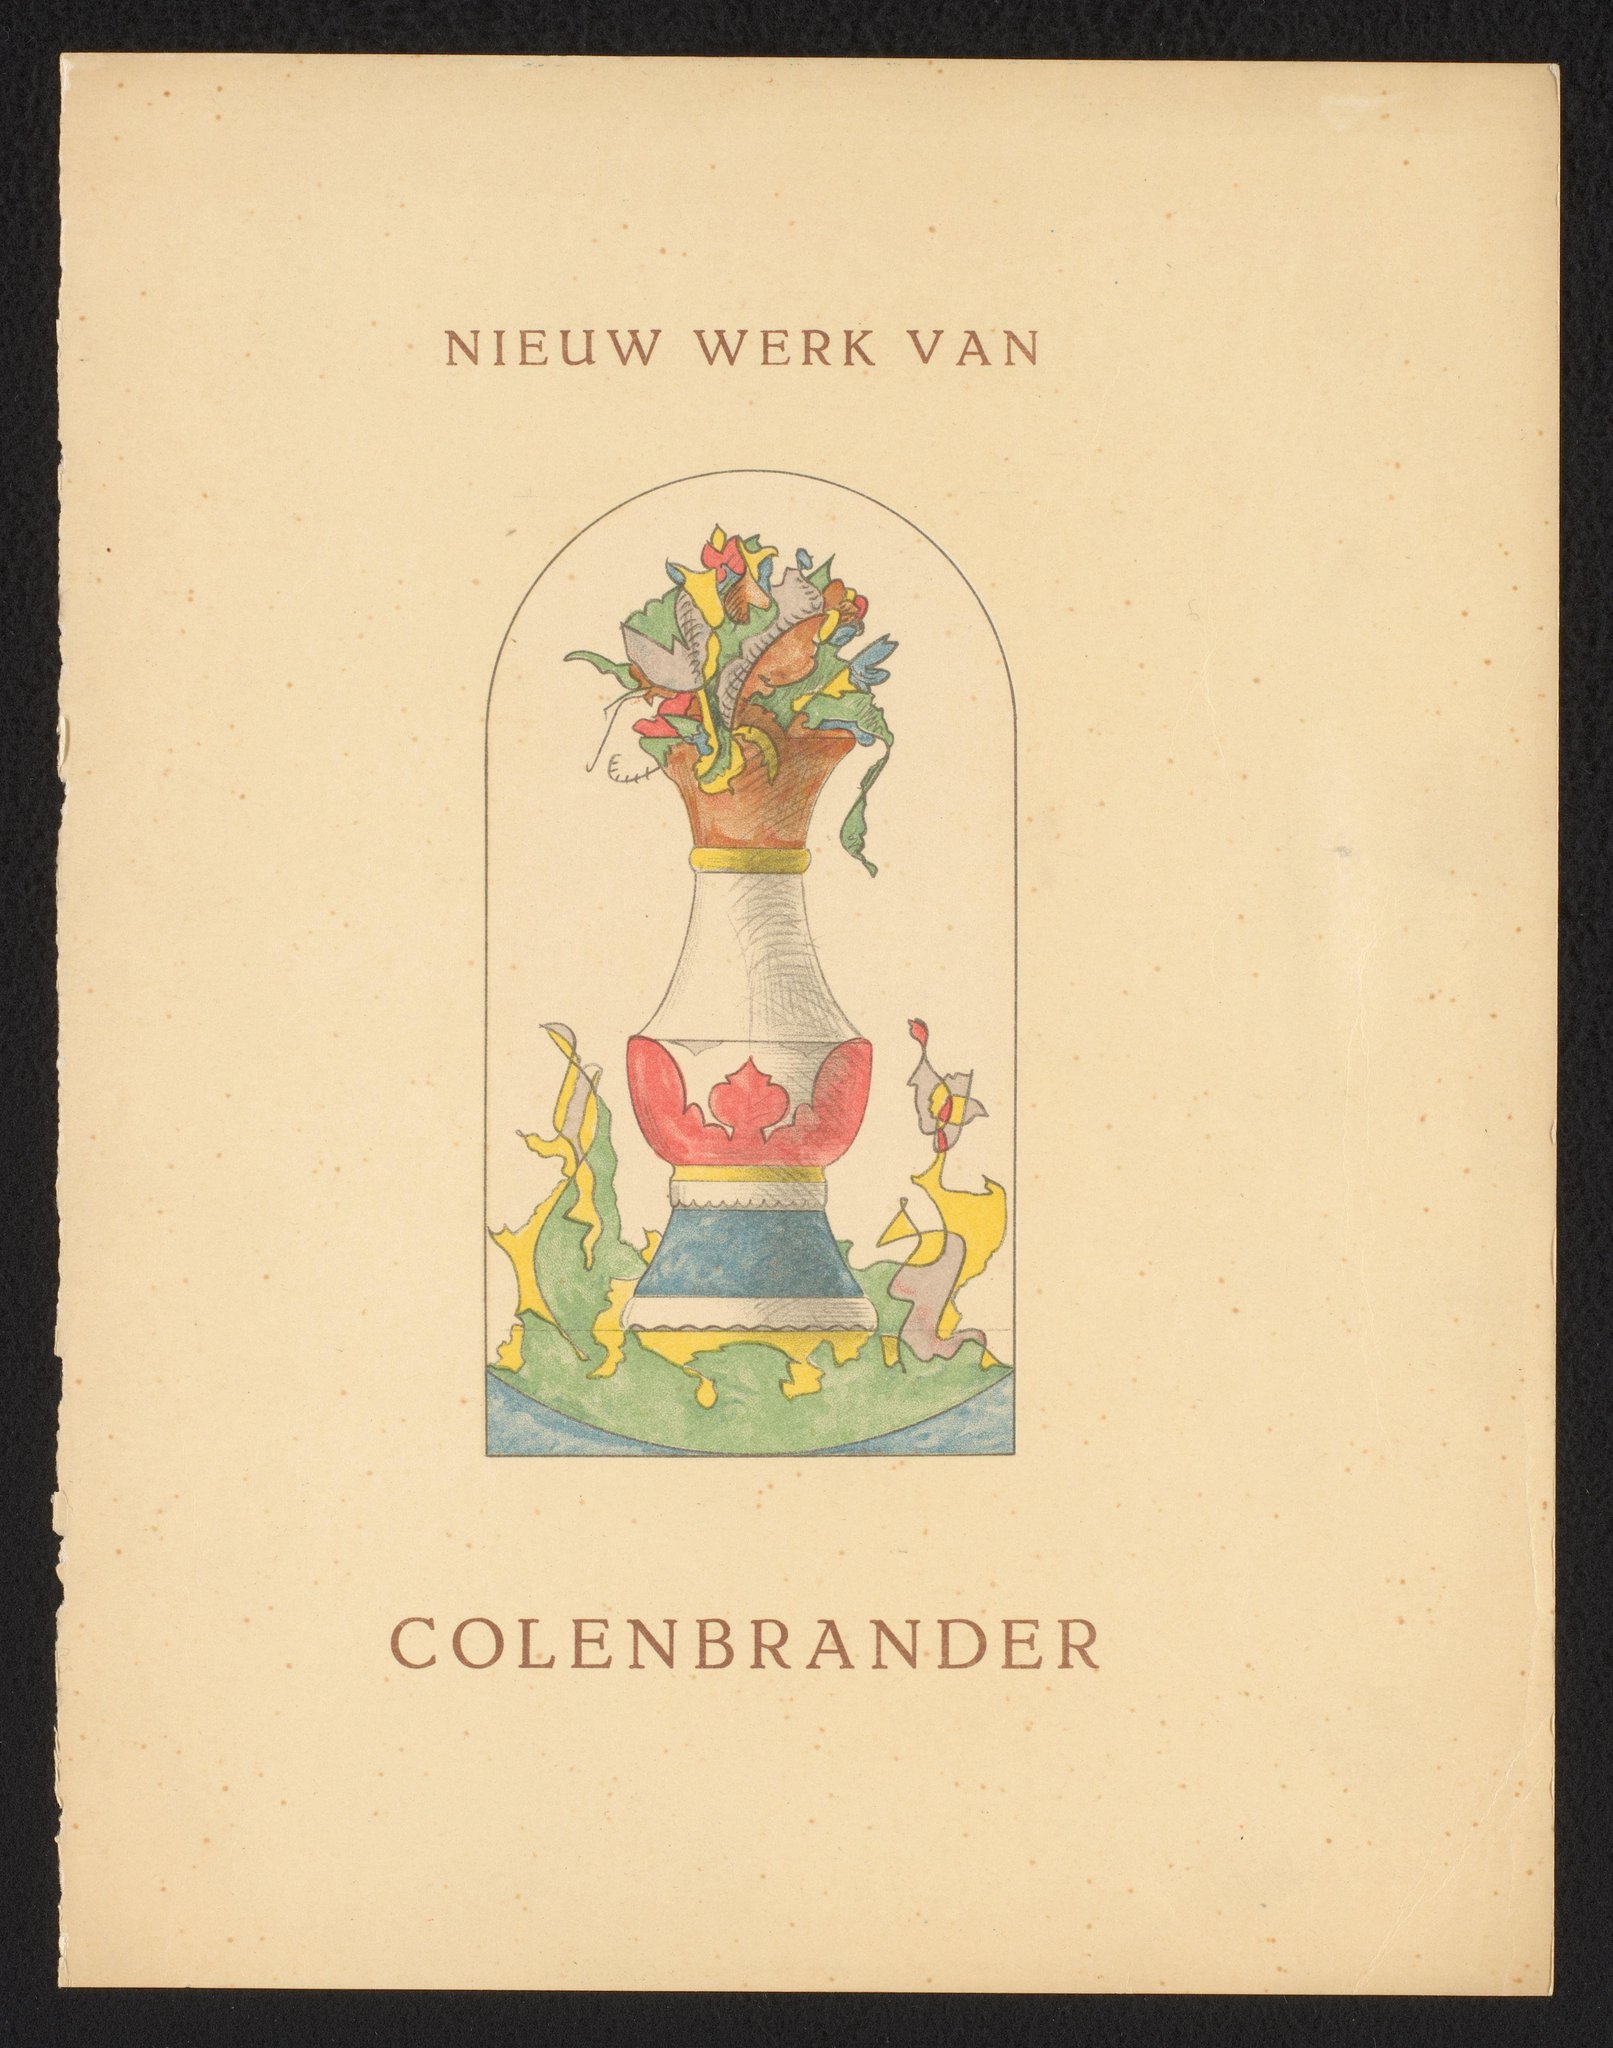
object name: titelblad, titelpagina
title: Nieuw werk van Colenbrander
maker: Anonymous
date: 1922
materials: paper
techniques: lithograph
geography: amsterdam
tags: book-cover, binding, art sale, auction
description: Titelpagina voor: Nieuw werk van Colenbrander. Amsterdam: Frederik Muller & Co., 1922.